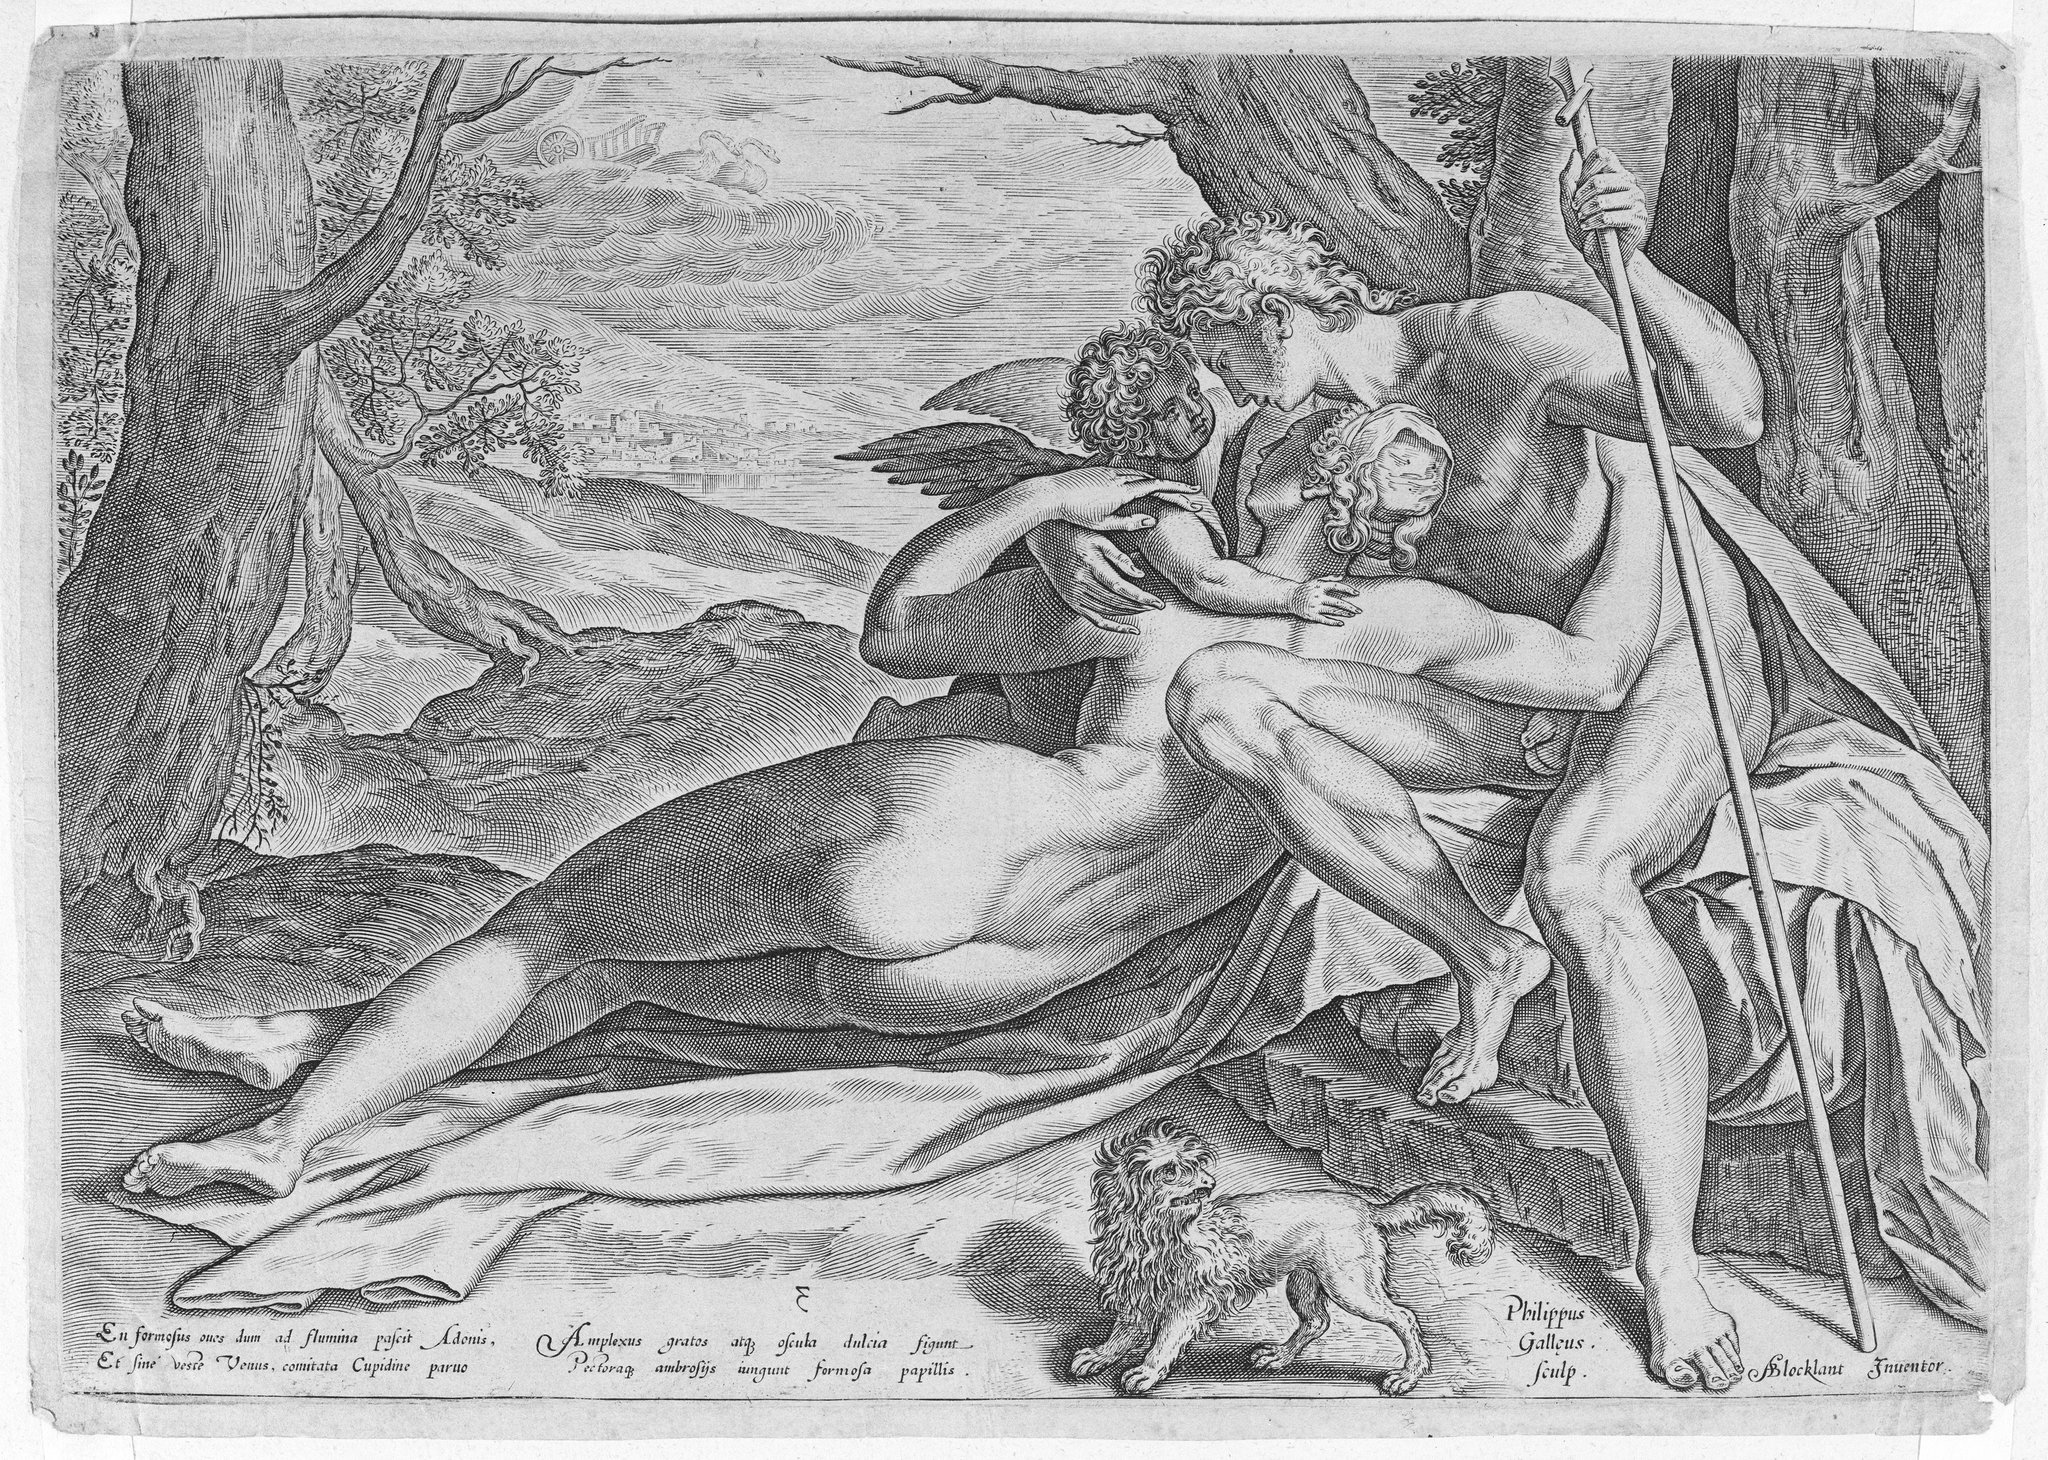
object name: print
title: Venus and Adonis, from "The Story of Adonis"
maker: philips galle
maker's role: artist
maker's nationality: netherlandish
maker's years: 1537-1612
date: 1579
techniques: engraving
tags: adonis,venus